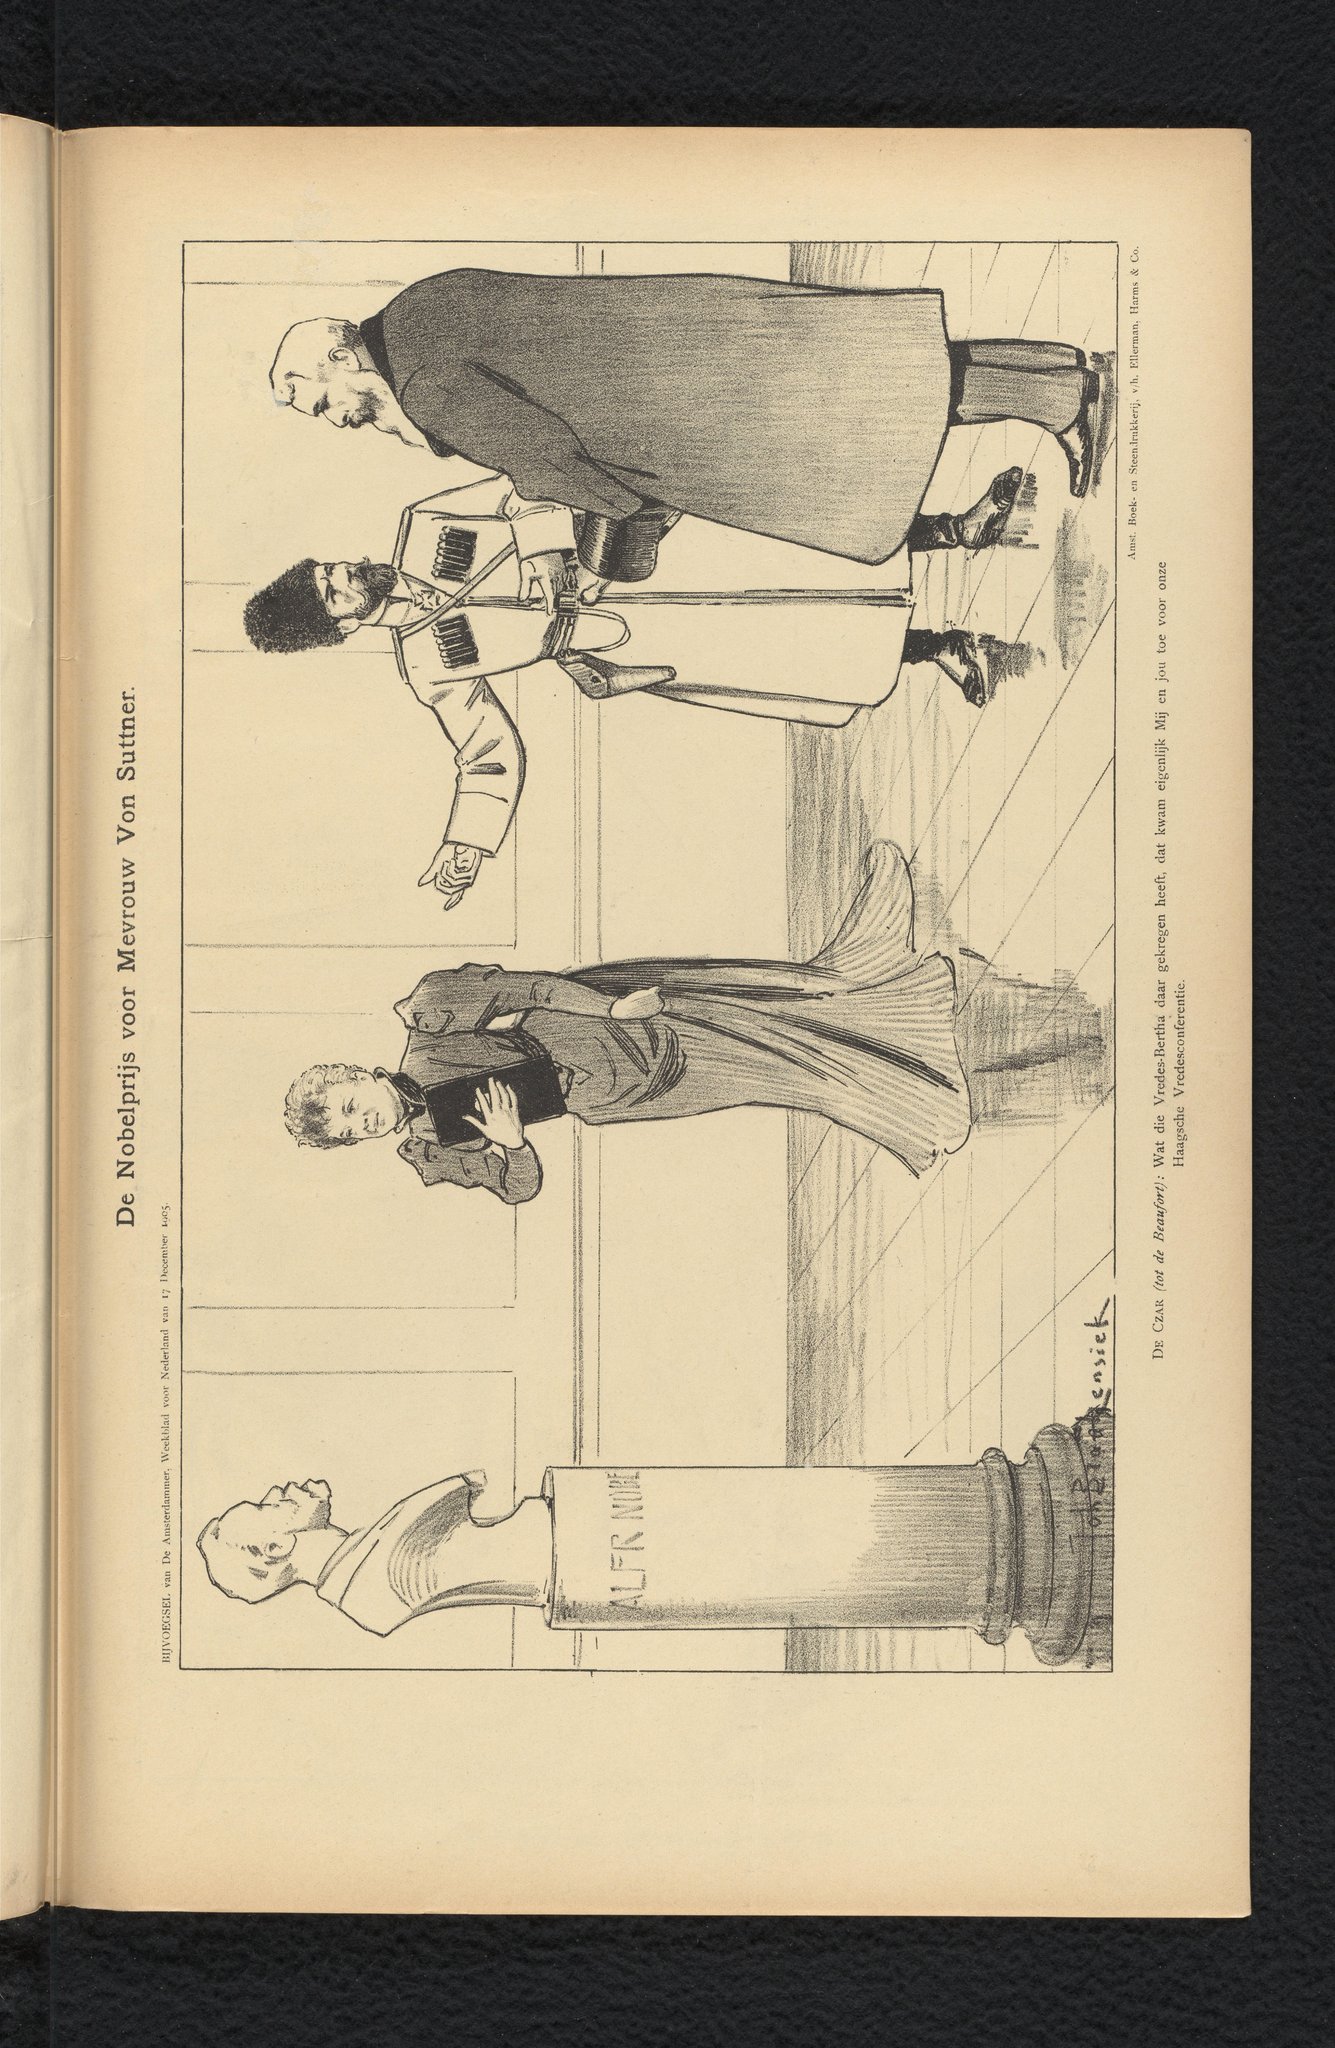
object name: cartoon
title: De Nobelprijs voor Mevrouw Von Suttner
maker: johan braakensiek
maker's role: draughtsman, print maker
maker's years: 1858-1940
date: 1905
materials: paper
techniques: lithograph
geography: netherlands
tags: the hague, anti-militarism, pacifism, political caricatures and satires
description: De Oostenrijkse pacifiste Bertha von Suttner ontvangt, als eerste vrouw, de Nobelprijs voor de Vrede. De Russische tsaar Nicolaas II vertelt tegen De Beaufort dat zij eigenlijk de prijs hadden verdiend voor de Haagse vredesconferentie van 1899.